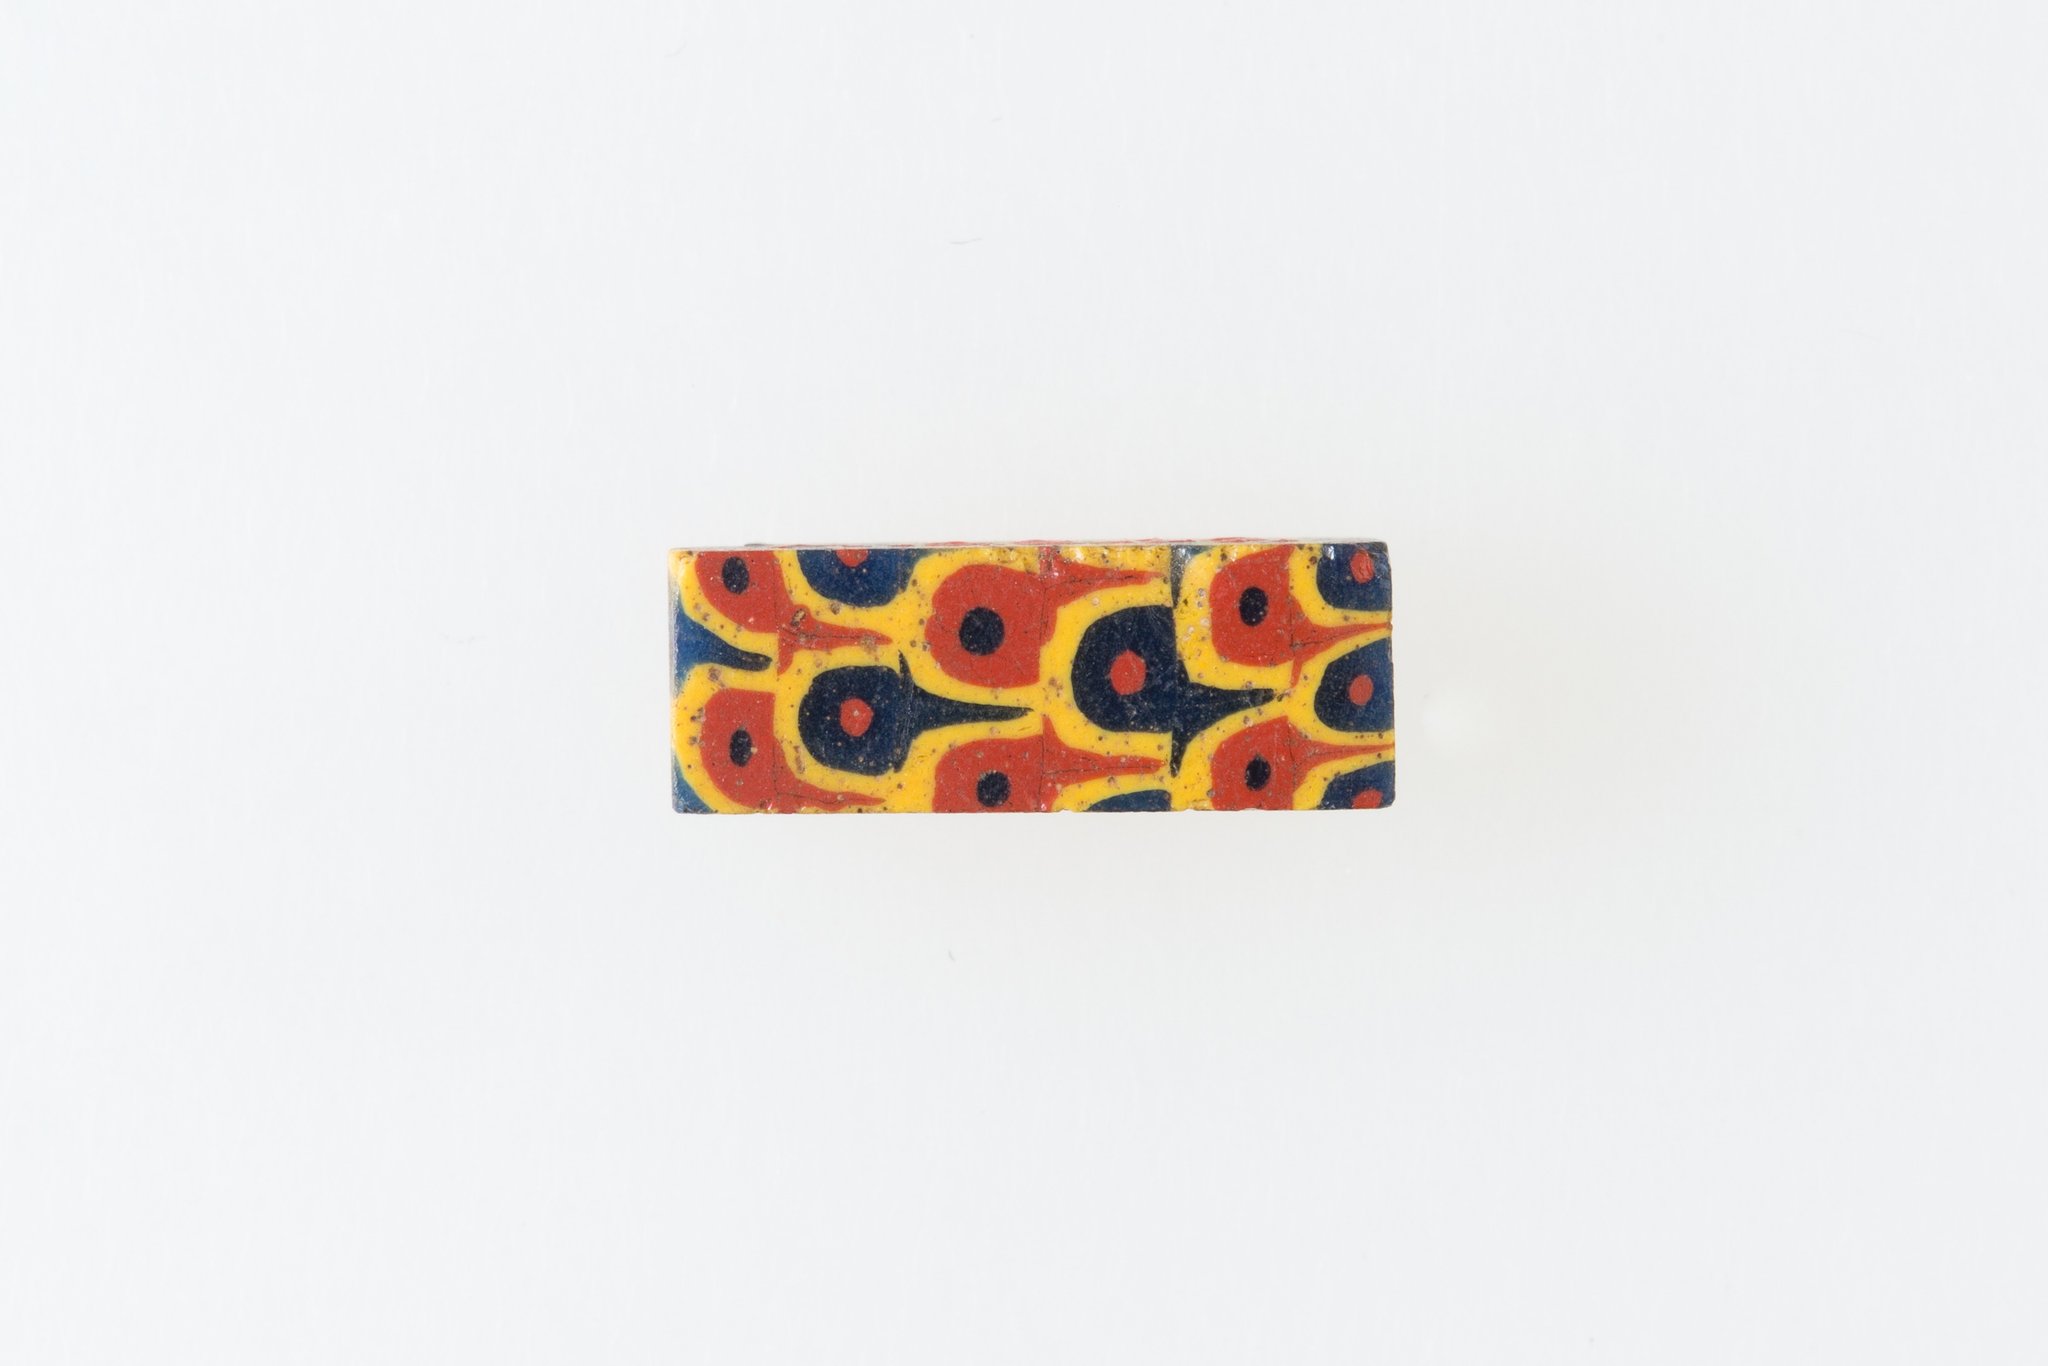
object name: inlay fragment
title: Inlay fragment, feather design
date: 200 BCE-100 CE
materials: glass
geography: egypt